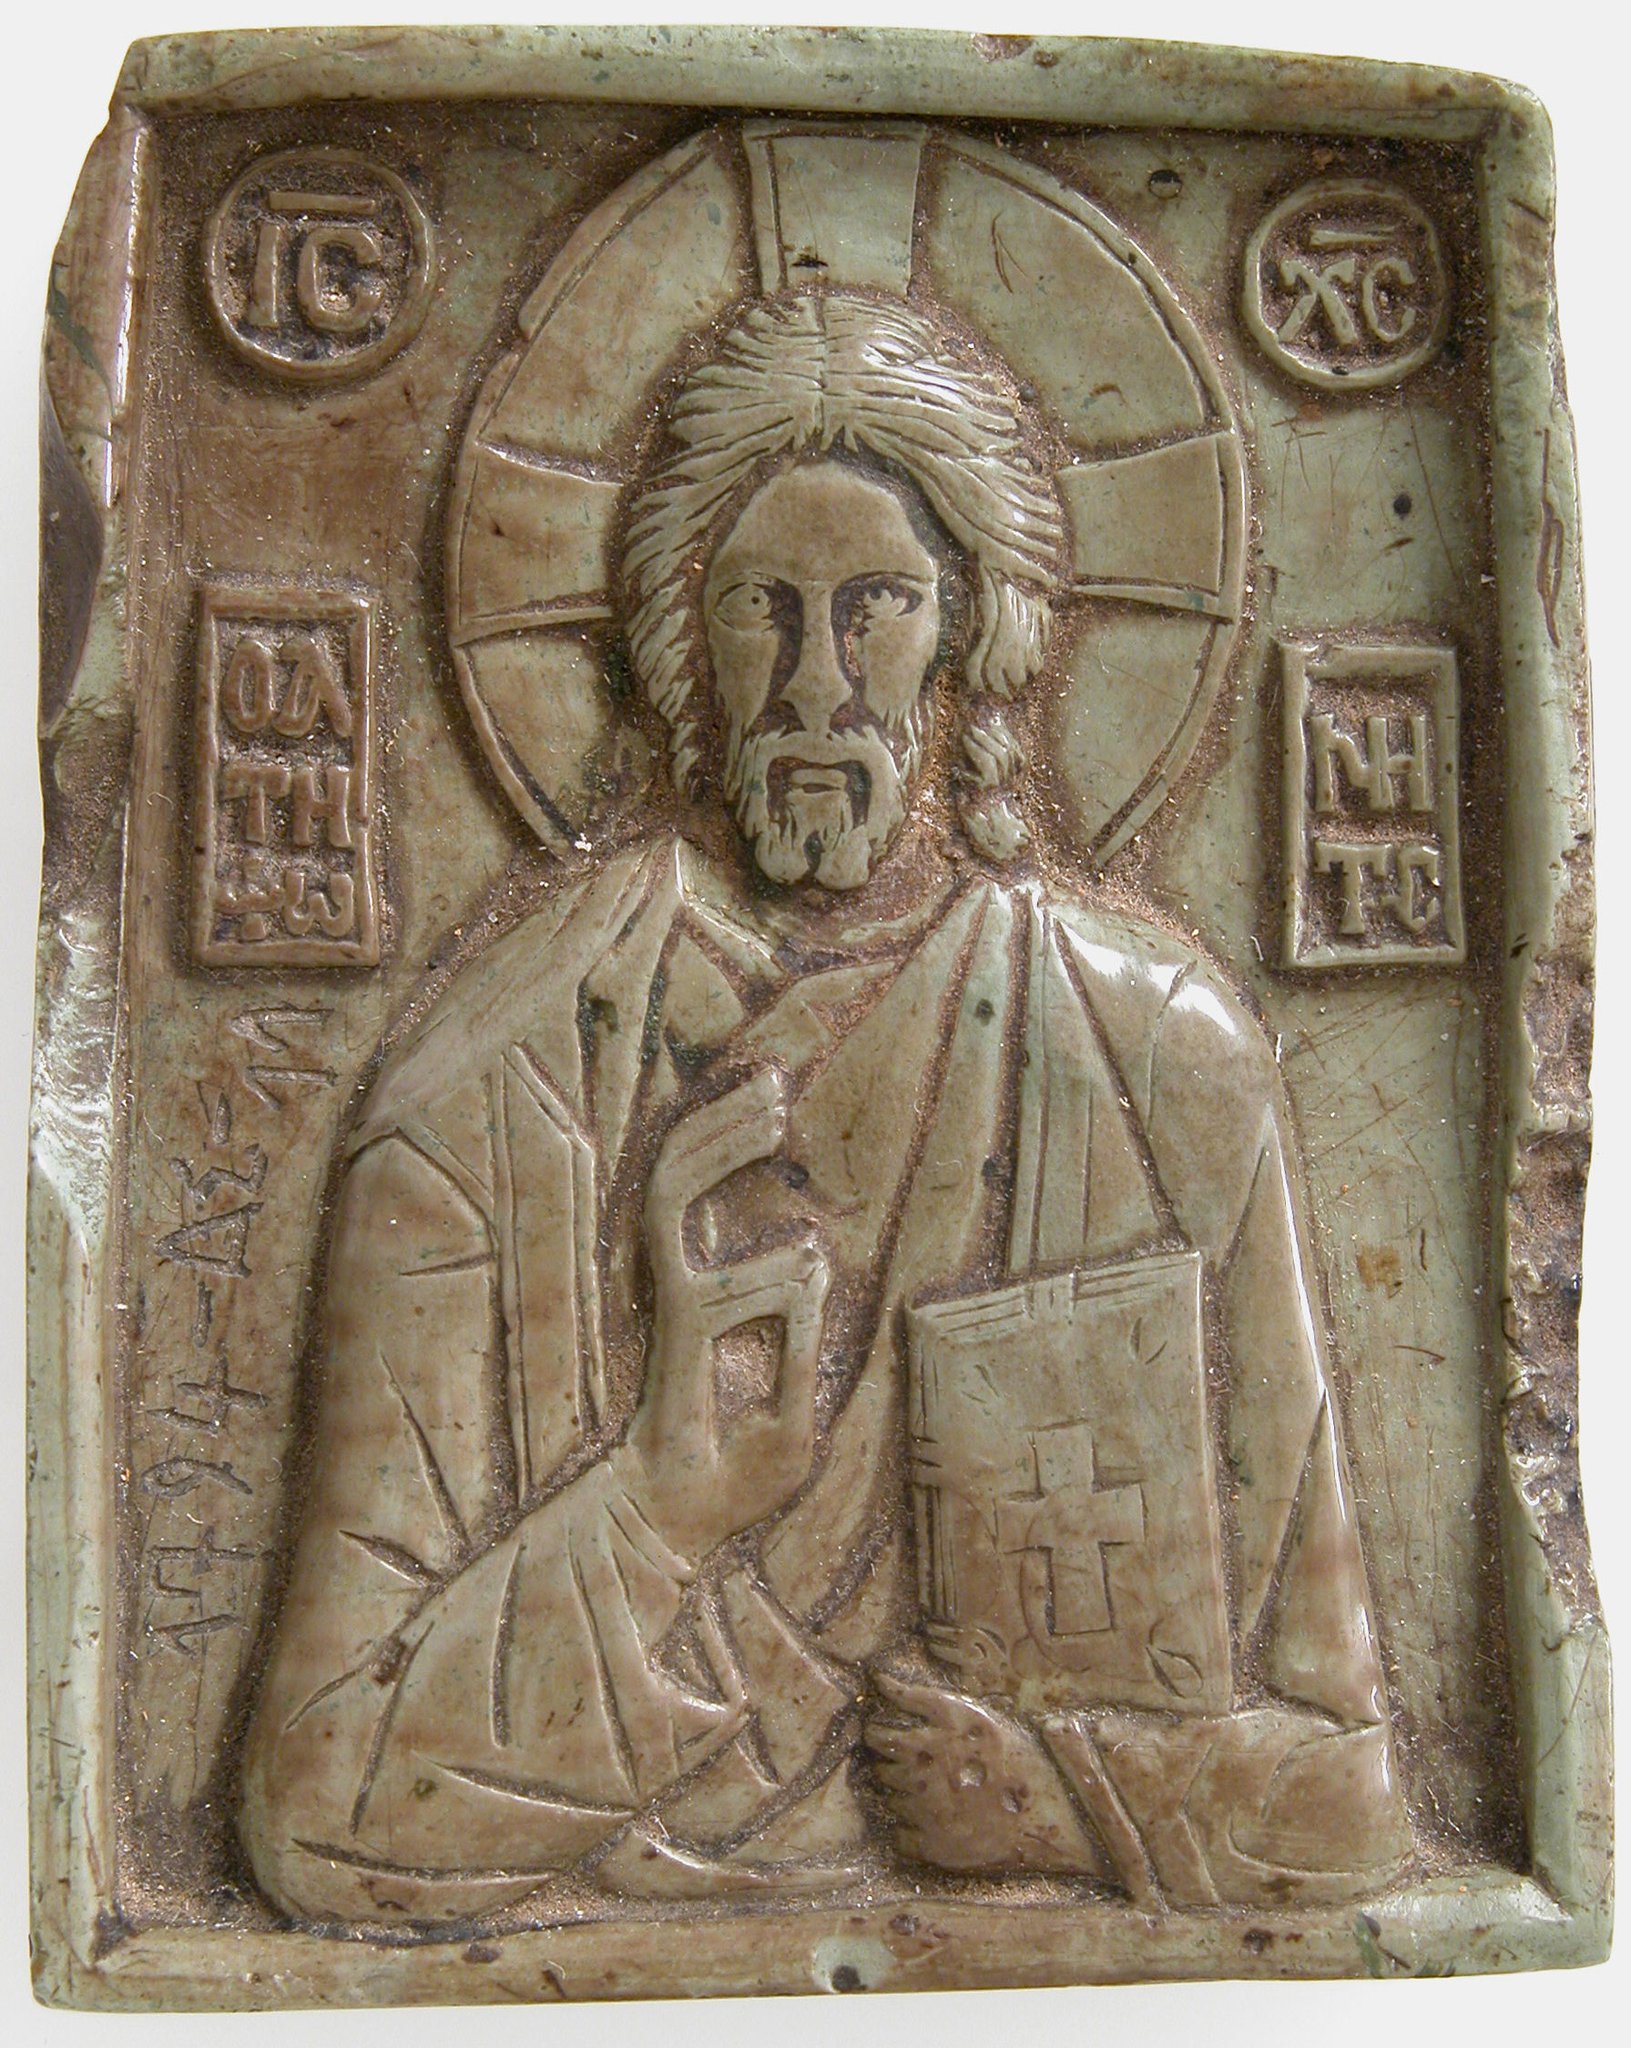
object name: plaque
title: Icon with Christ Pantokrator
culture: byzantine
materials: stone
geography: greece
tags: christ